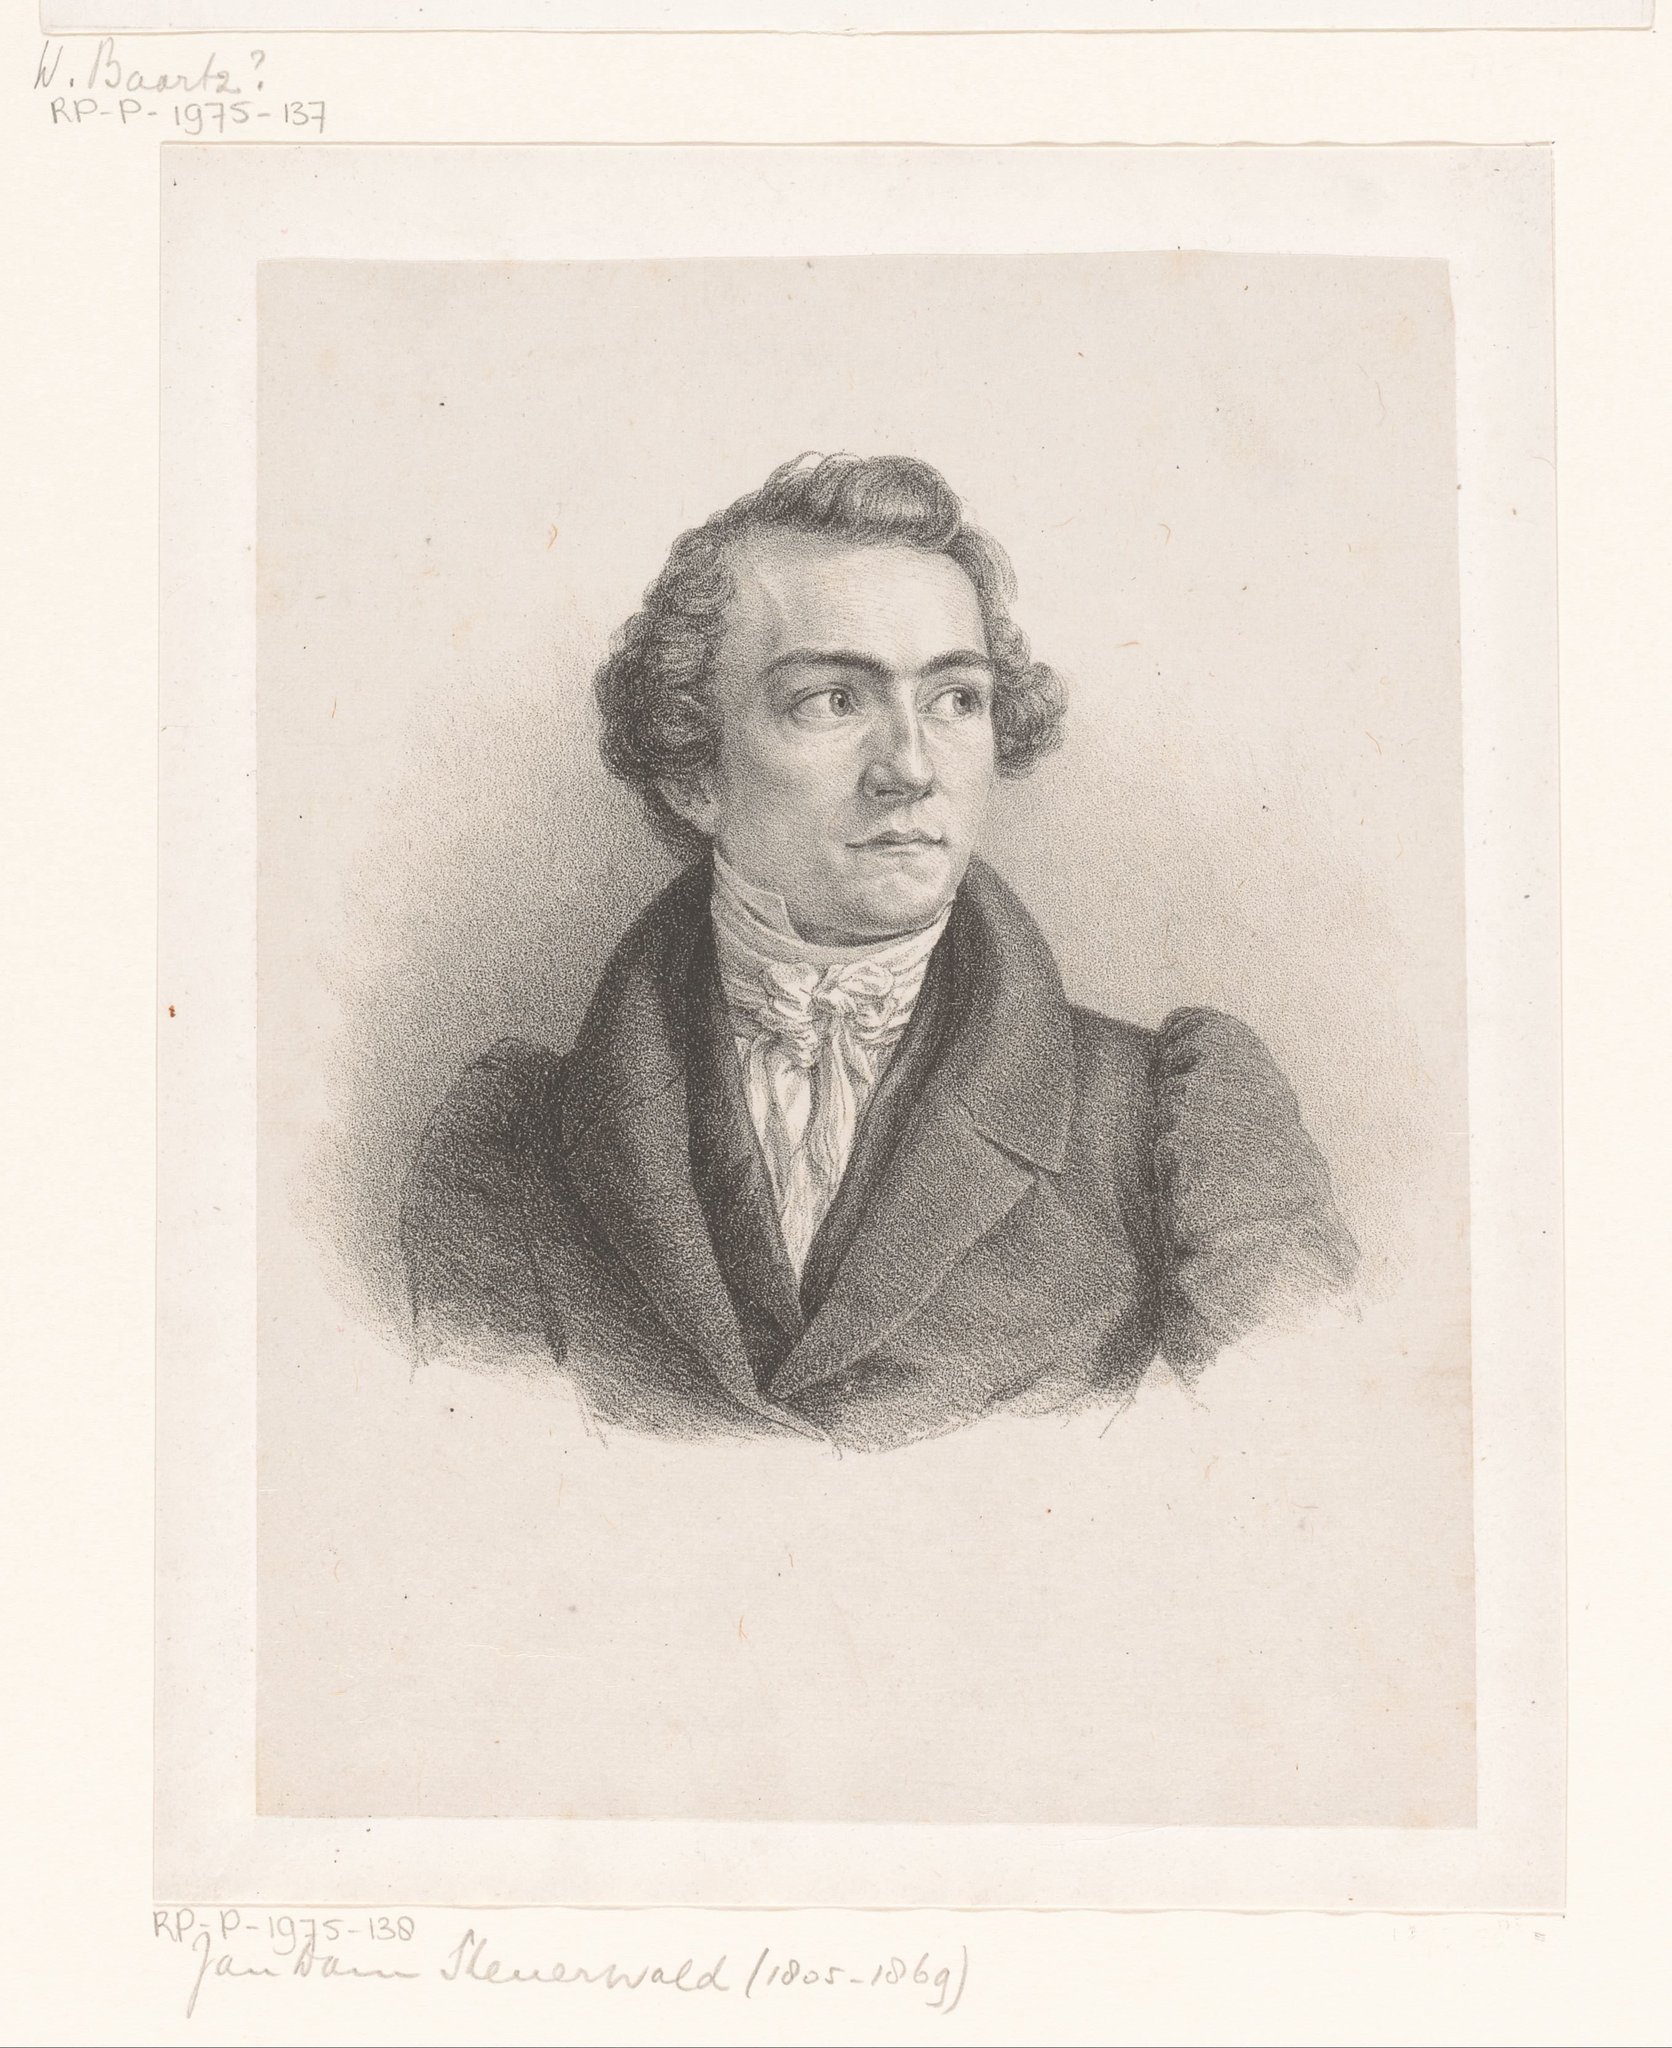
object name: print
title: Portret van Jan Dam Steuerwald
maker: christian heinrich gottlieb steuerwald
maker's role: draughtsman, print maker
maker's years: 1802-1874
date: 1825-1874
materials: paper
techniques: lithograph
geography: dordrecht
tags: the hague, print maker, jan dam steuerwald, historical persons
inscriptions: collector's mark: Lugt 2228, inscription: ‘4a / 10-9-'75’